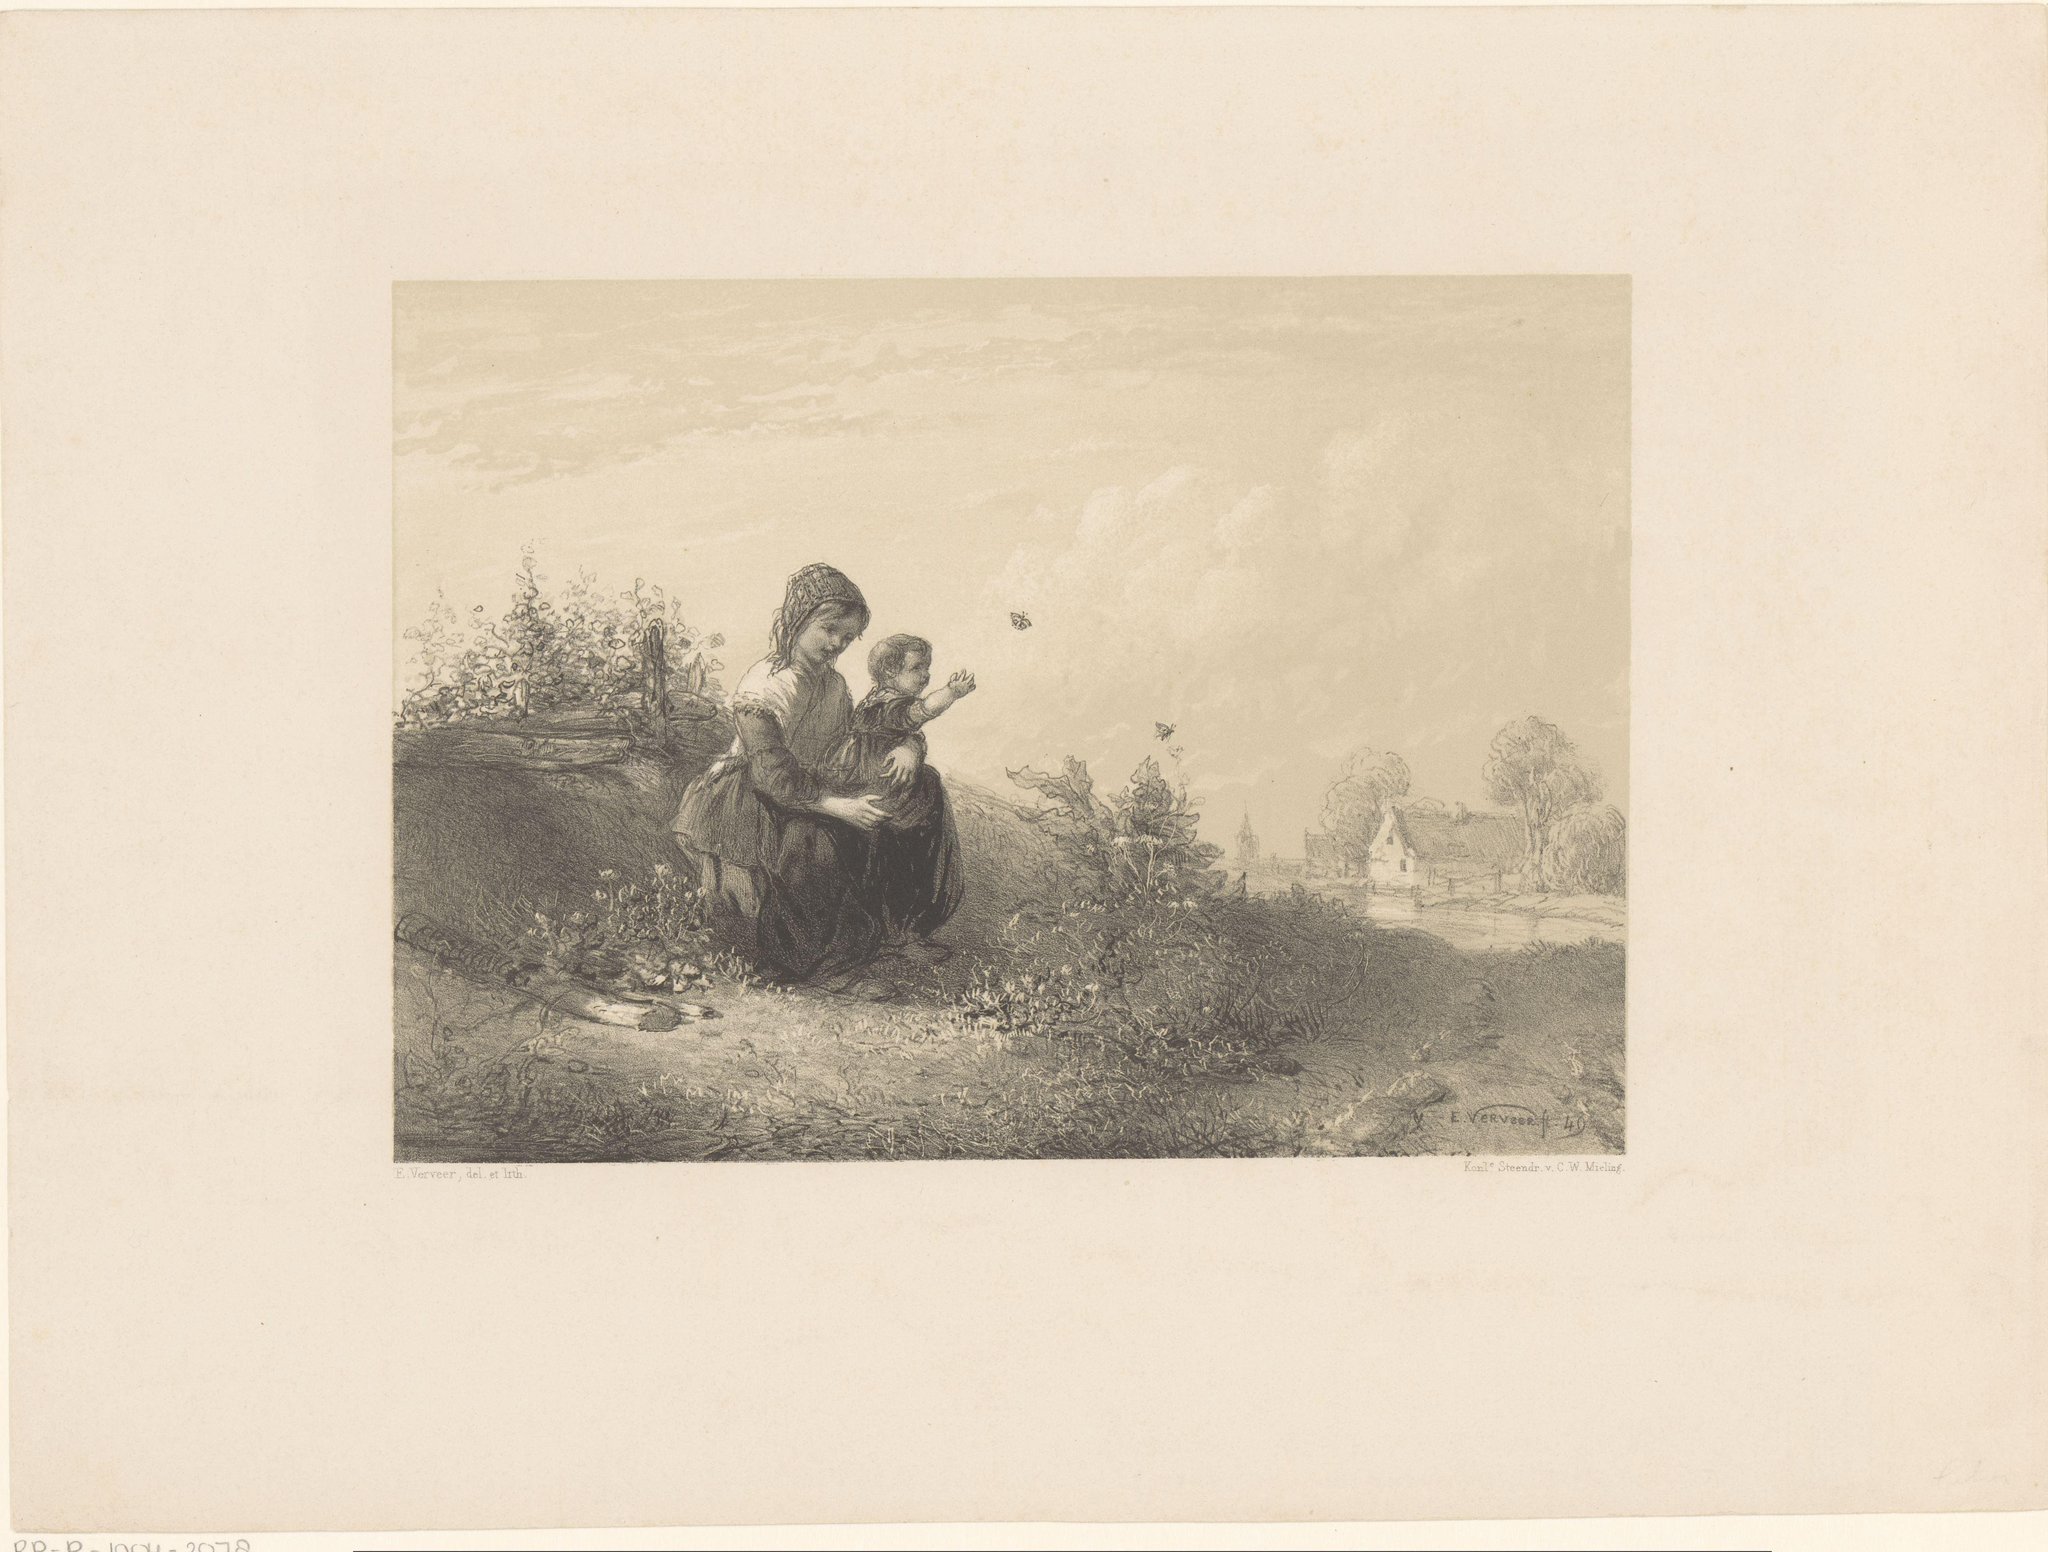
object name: print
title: Meisje met kind op schoot in landschap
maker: elchanon verveer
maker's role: draughtsman, print maker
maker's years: 1826-1900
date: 1849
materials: paper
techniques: tone lithography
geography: the hague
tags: girl (child between toddler and youth), insects: butterfly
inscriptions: collector's mark: Lugt 2228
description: In een landschap zit een meisje met een kind op schoot dat haar hand naar een vlinder uitsteekt.